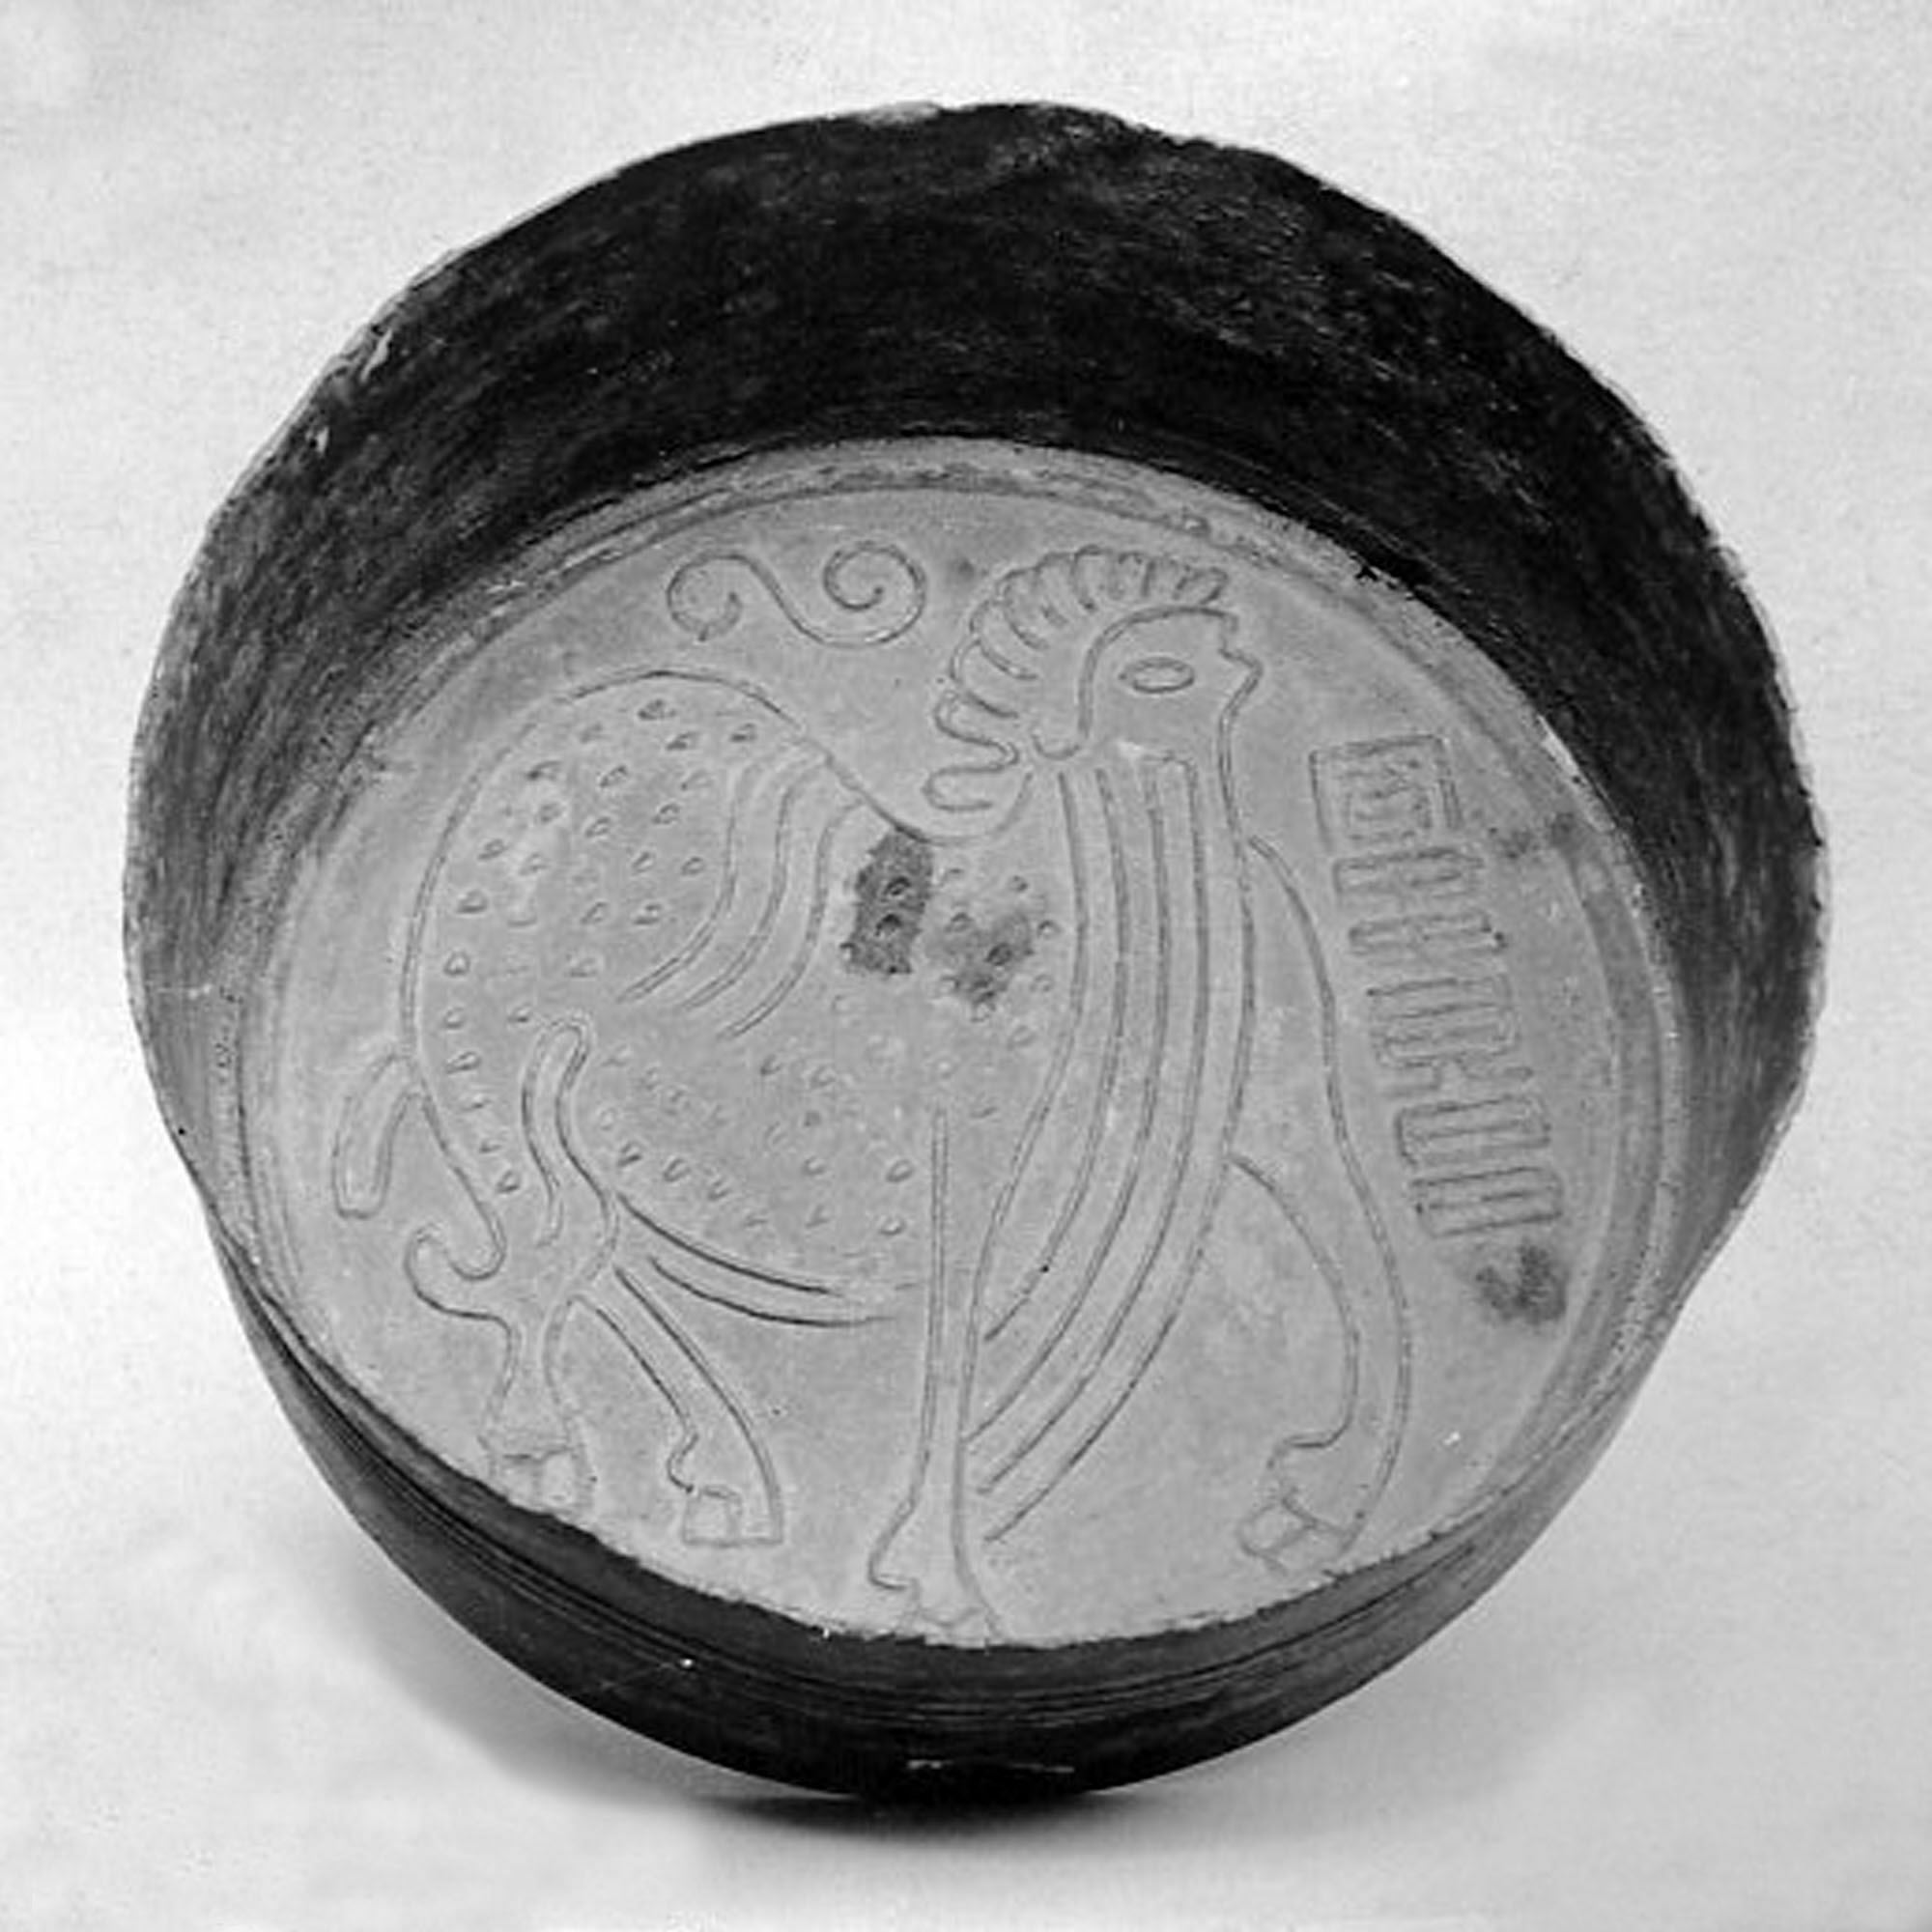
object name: bowl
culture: chinese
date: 206 BCE-220 CE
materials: pewter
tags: animals